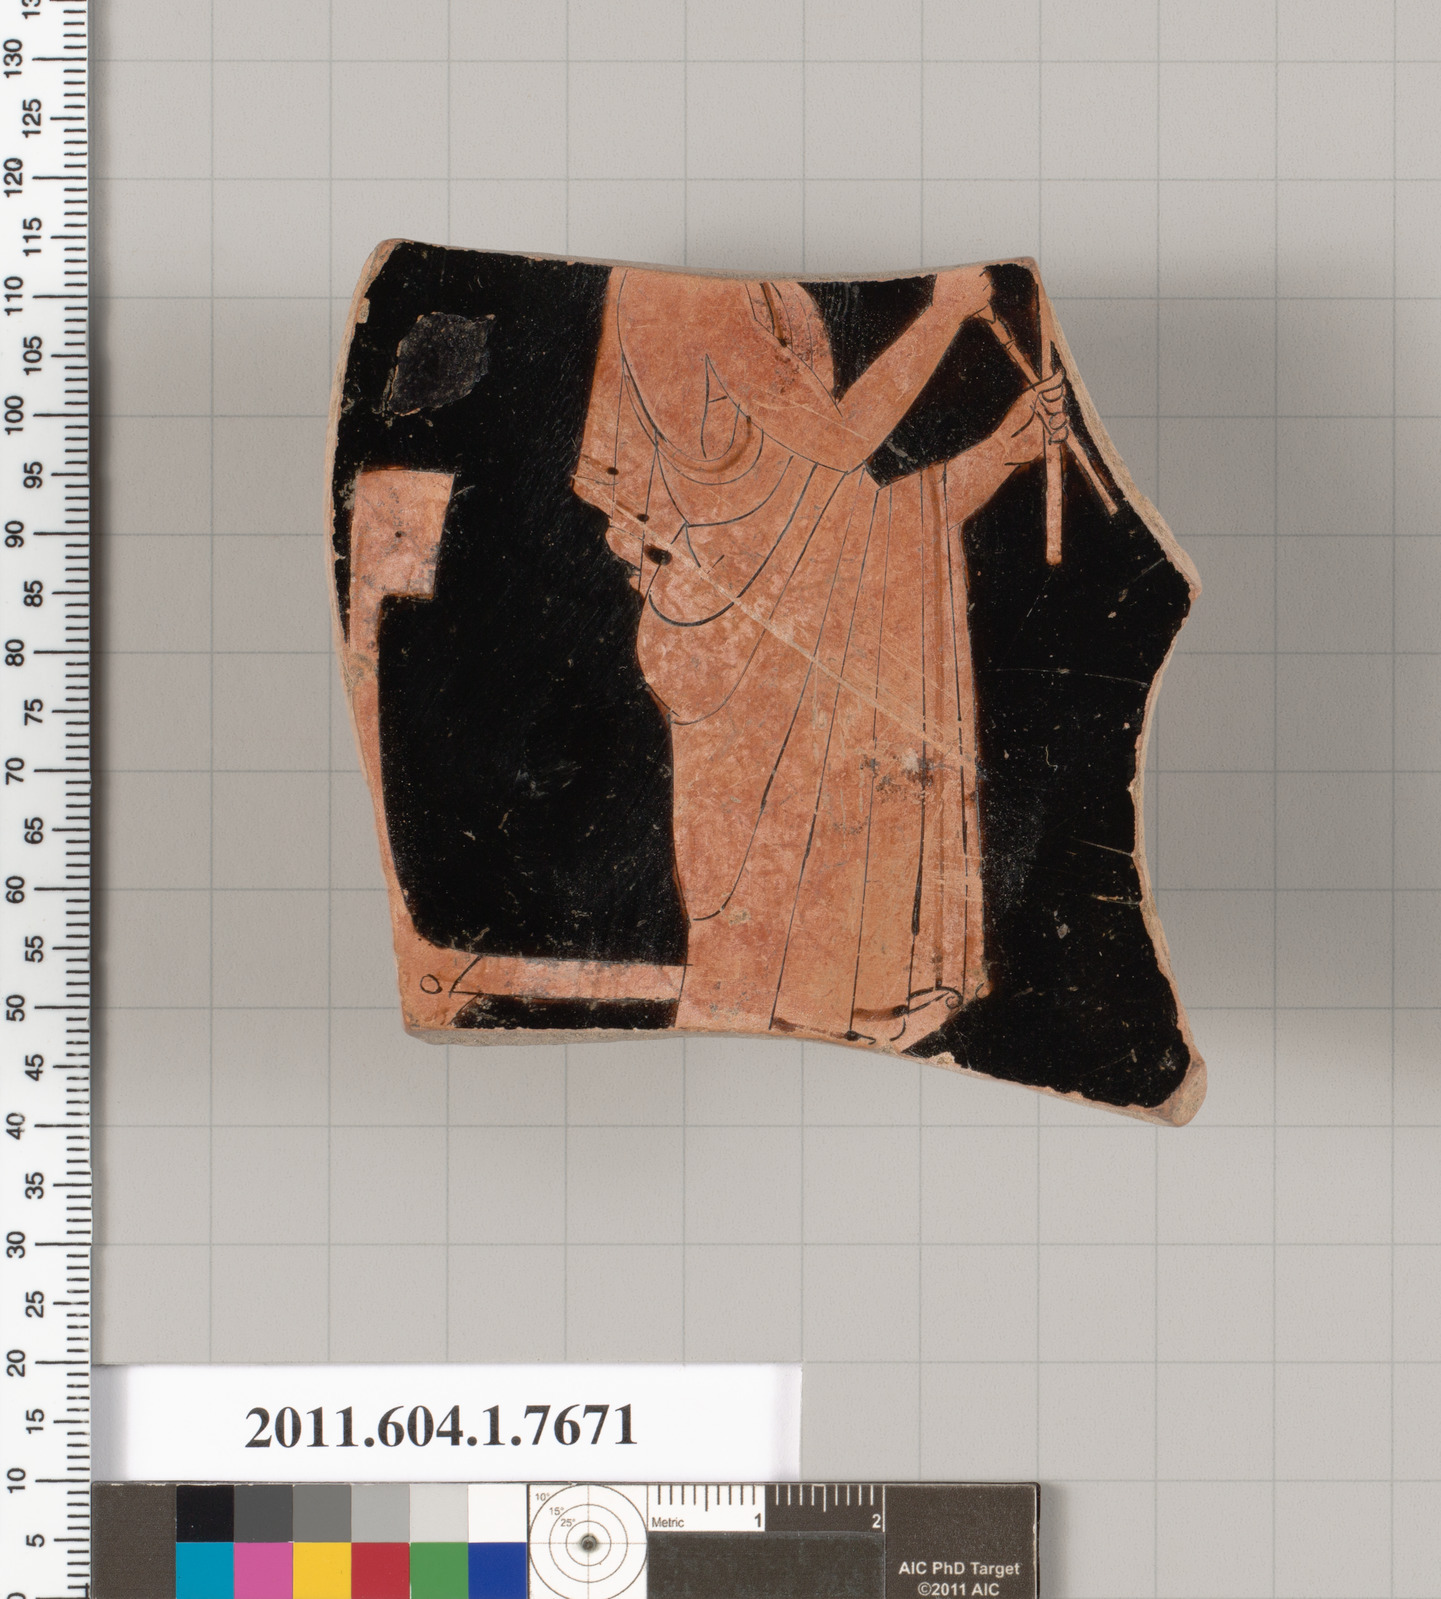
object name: kylix fragment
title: Terracotta fragment of a kylix (drinking cup)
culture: greek, attic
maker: makron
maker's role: artist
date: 480-470 BCE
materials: terracotta